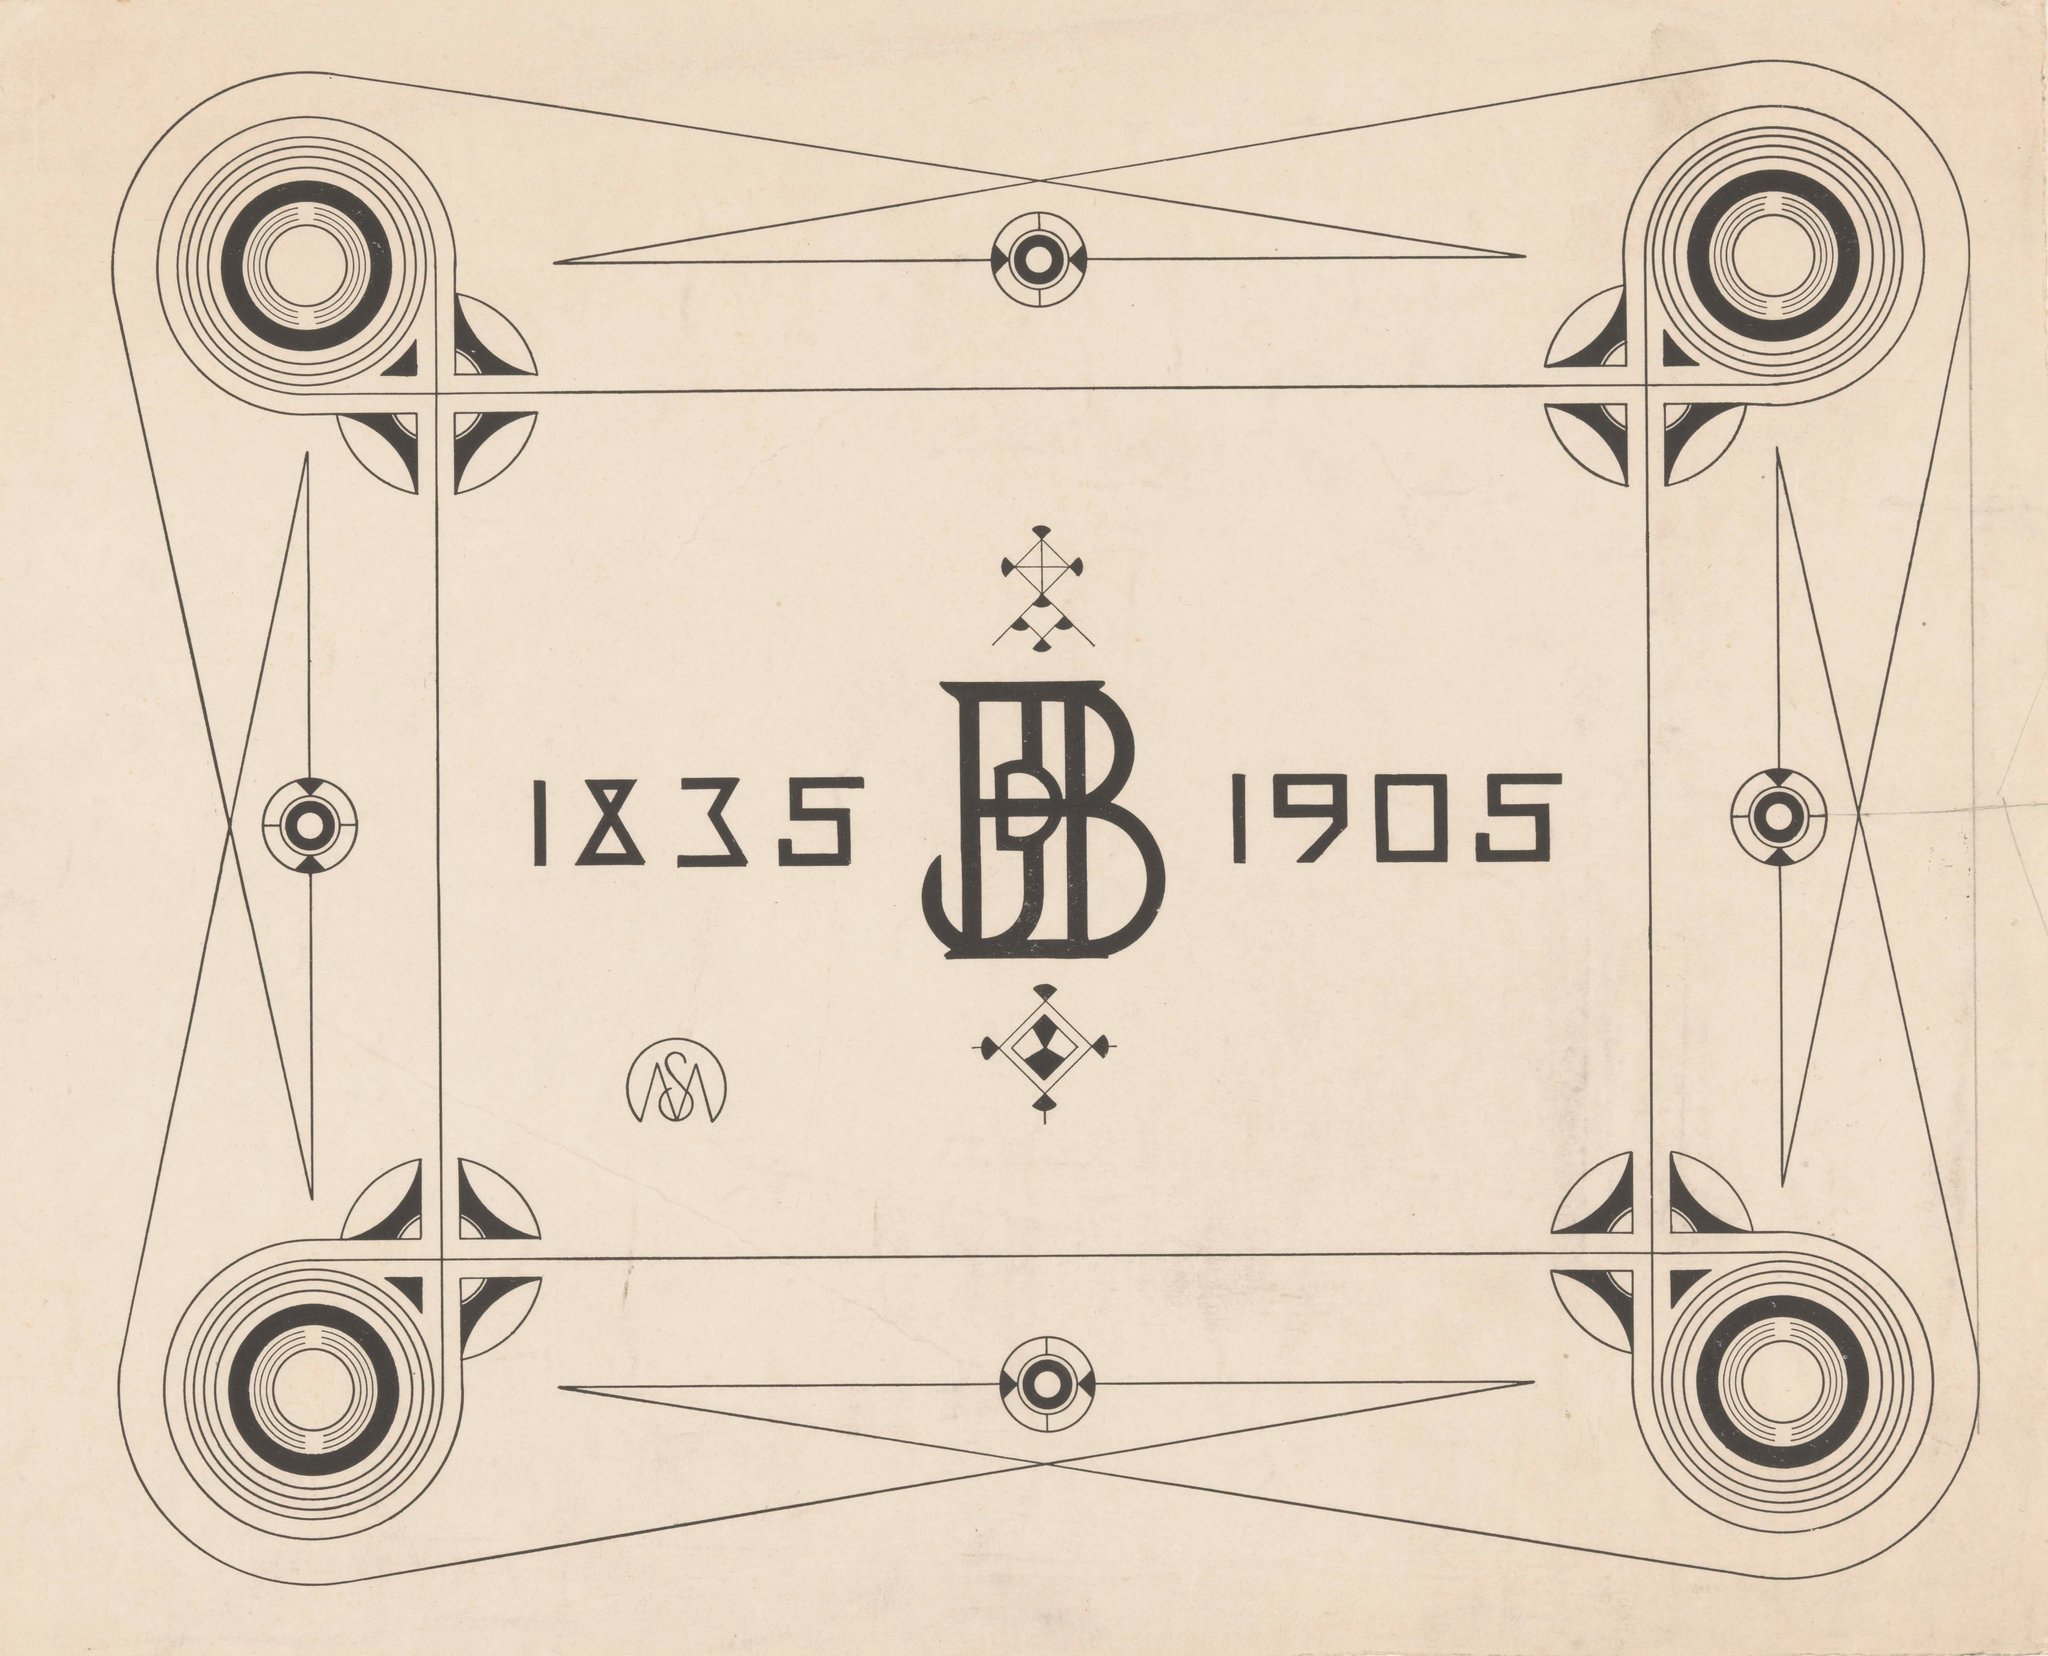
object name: print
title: Ornament JHdB 1835/1905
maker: samuel jessurun de mesquita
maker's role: draughtsman, print maker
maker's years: 1868-1944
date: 1900-1905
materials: paper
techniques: letterpress printing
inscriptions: collector's mark: Lugt 2228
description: Ornament met in de vier hoeken concentrische cirkels, in het midden een monogram.